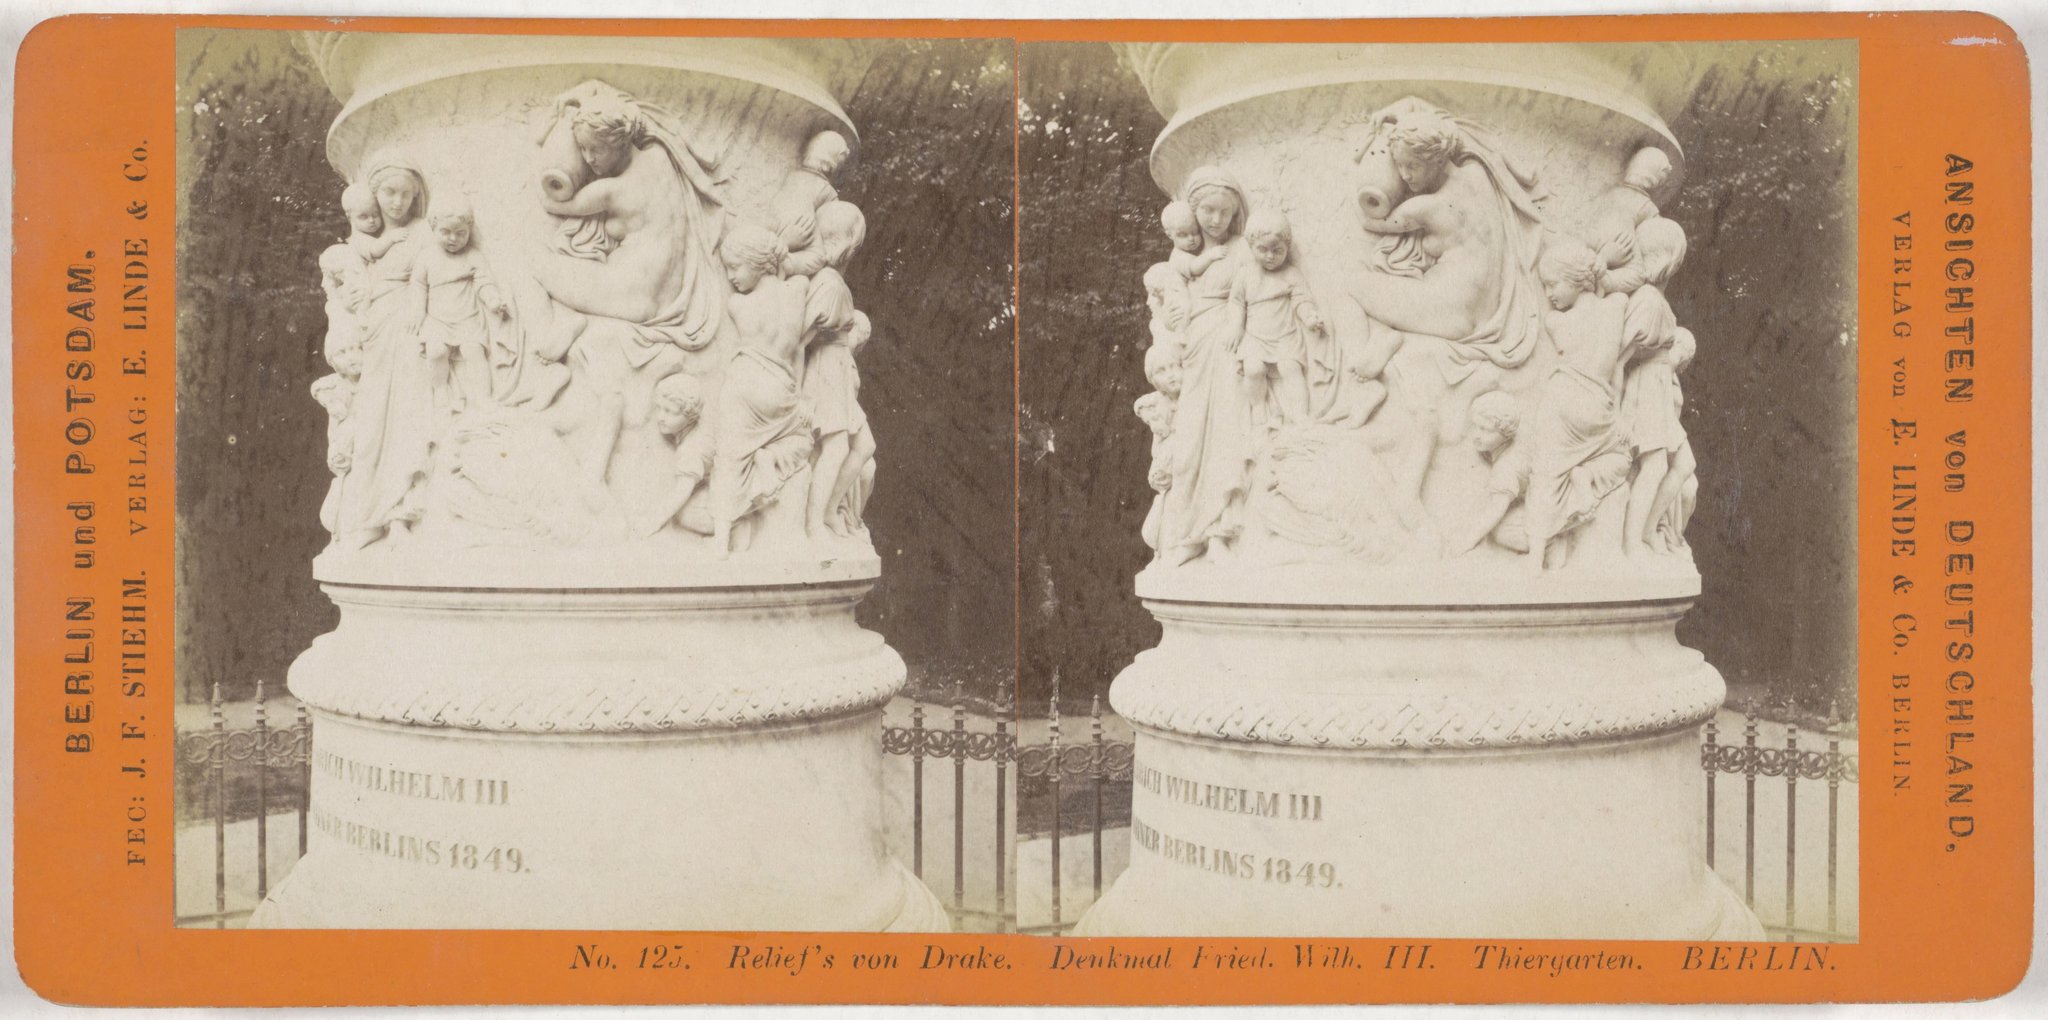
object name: stereograph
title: Ansichten von Deutschland / Berlin und Potsdam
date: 1868-1870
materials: cardboard, paper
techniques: albumen print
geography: berlin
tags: pedestal of a piece of sculpture (perhaps in the form of a herm)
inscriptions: number: ‘No.125’